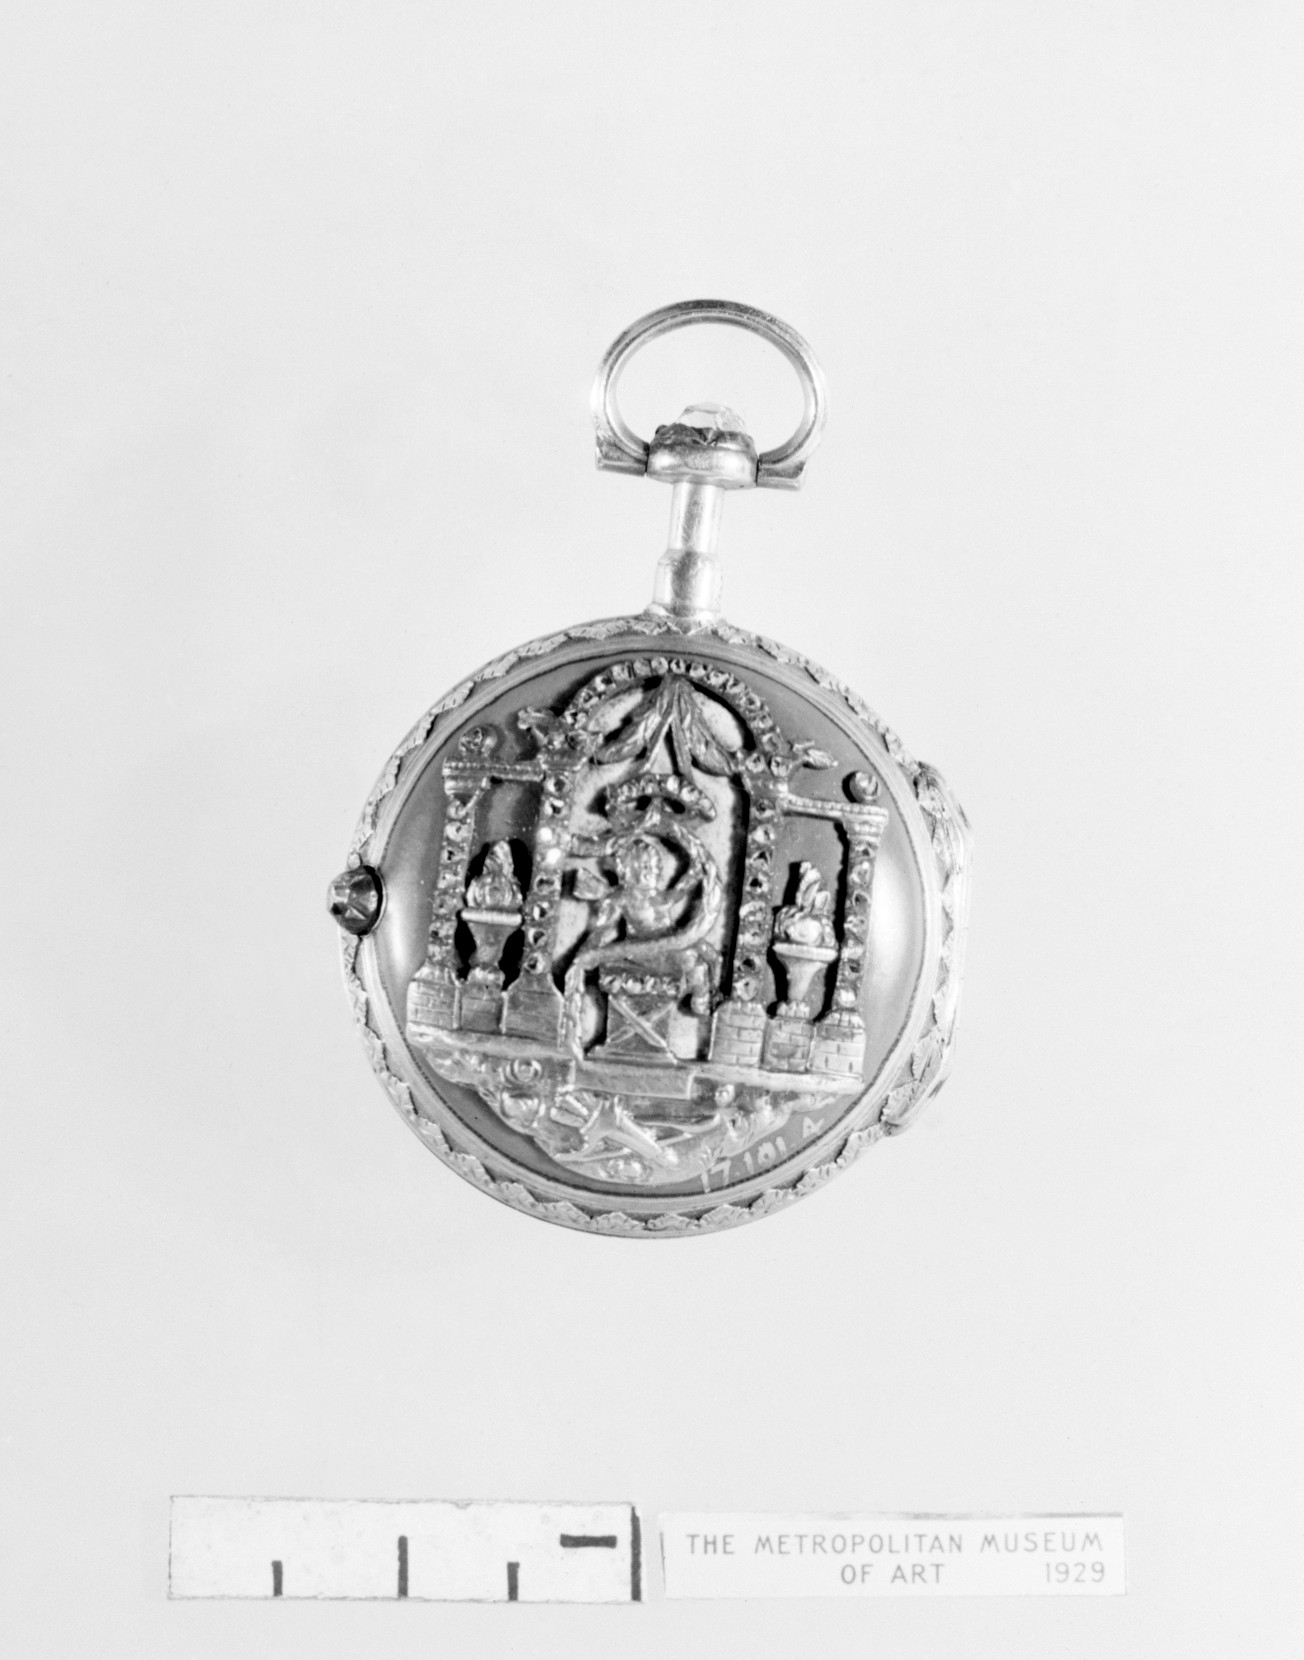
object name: watch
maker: jean antoine lépine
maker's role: maker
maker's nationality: french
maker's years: 1720-1814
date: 1767-1800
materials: enamel, gold